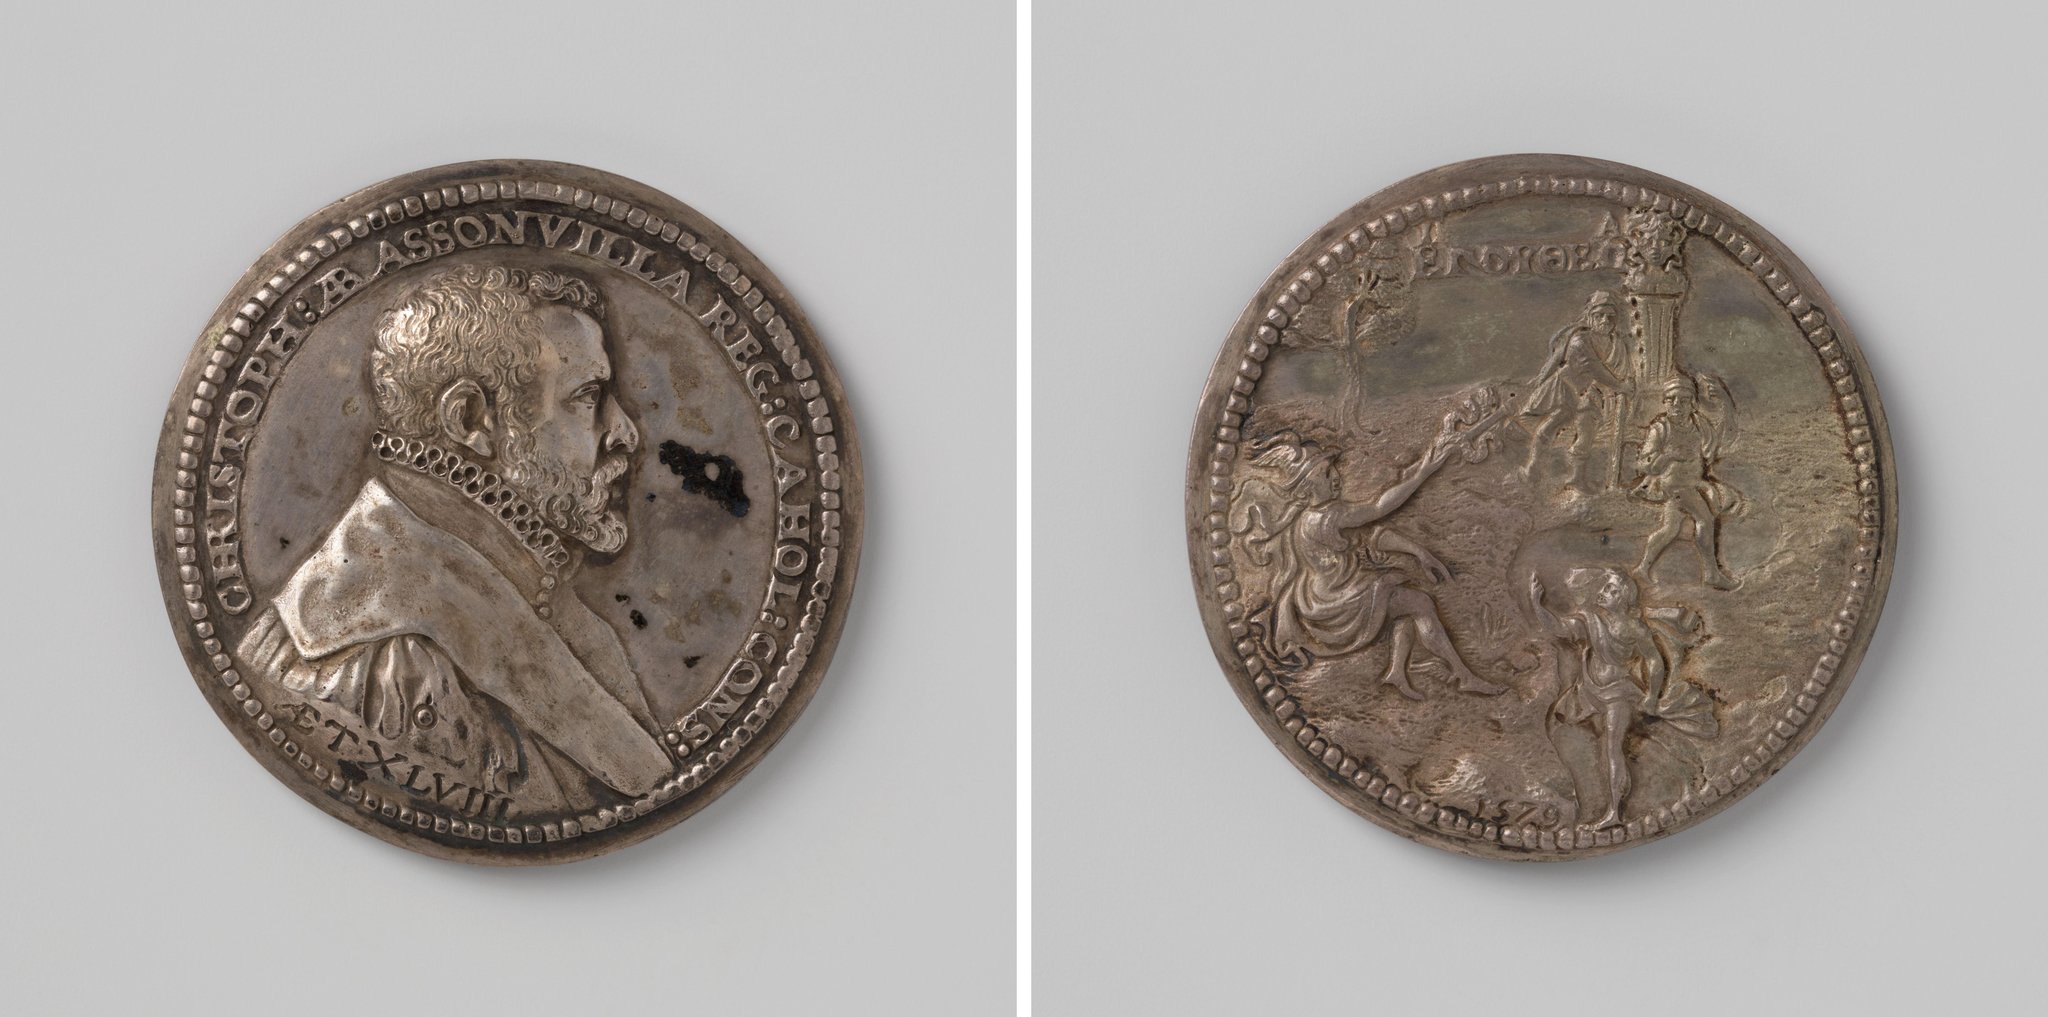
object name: history medal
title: Christophe d'Assonleville, raadsheer van Filips II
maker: jacques jonghelinck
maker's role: medailleur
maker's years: 1530-1606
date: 1579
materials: silver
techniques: casting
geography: antwerp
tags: philip ii of spain, brussels